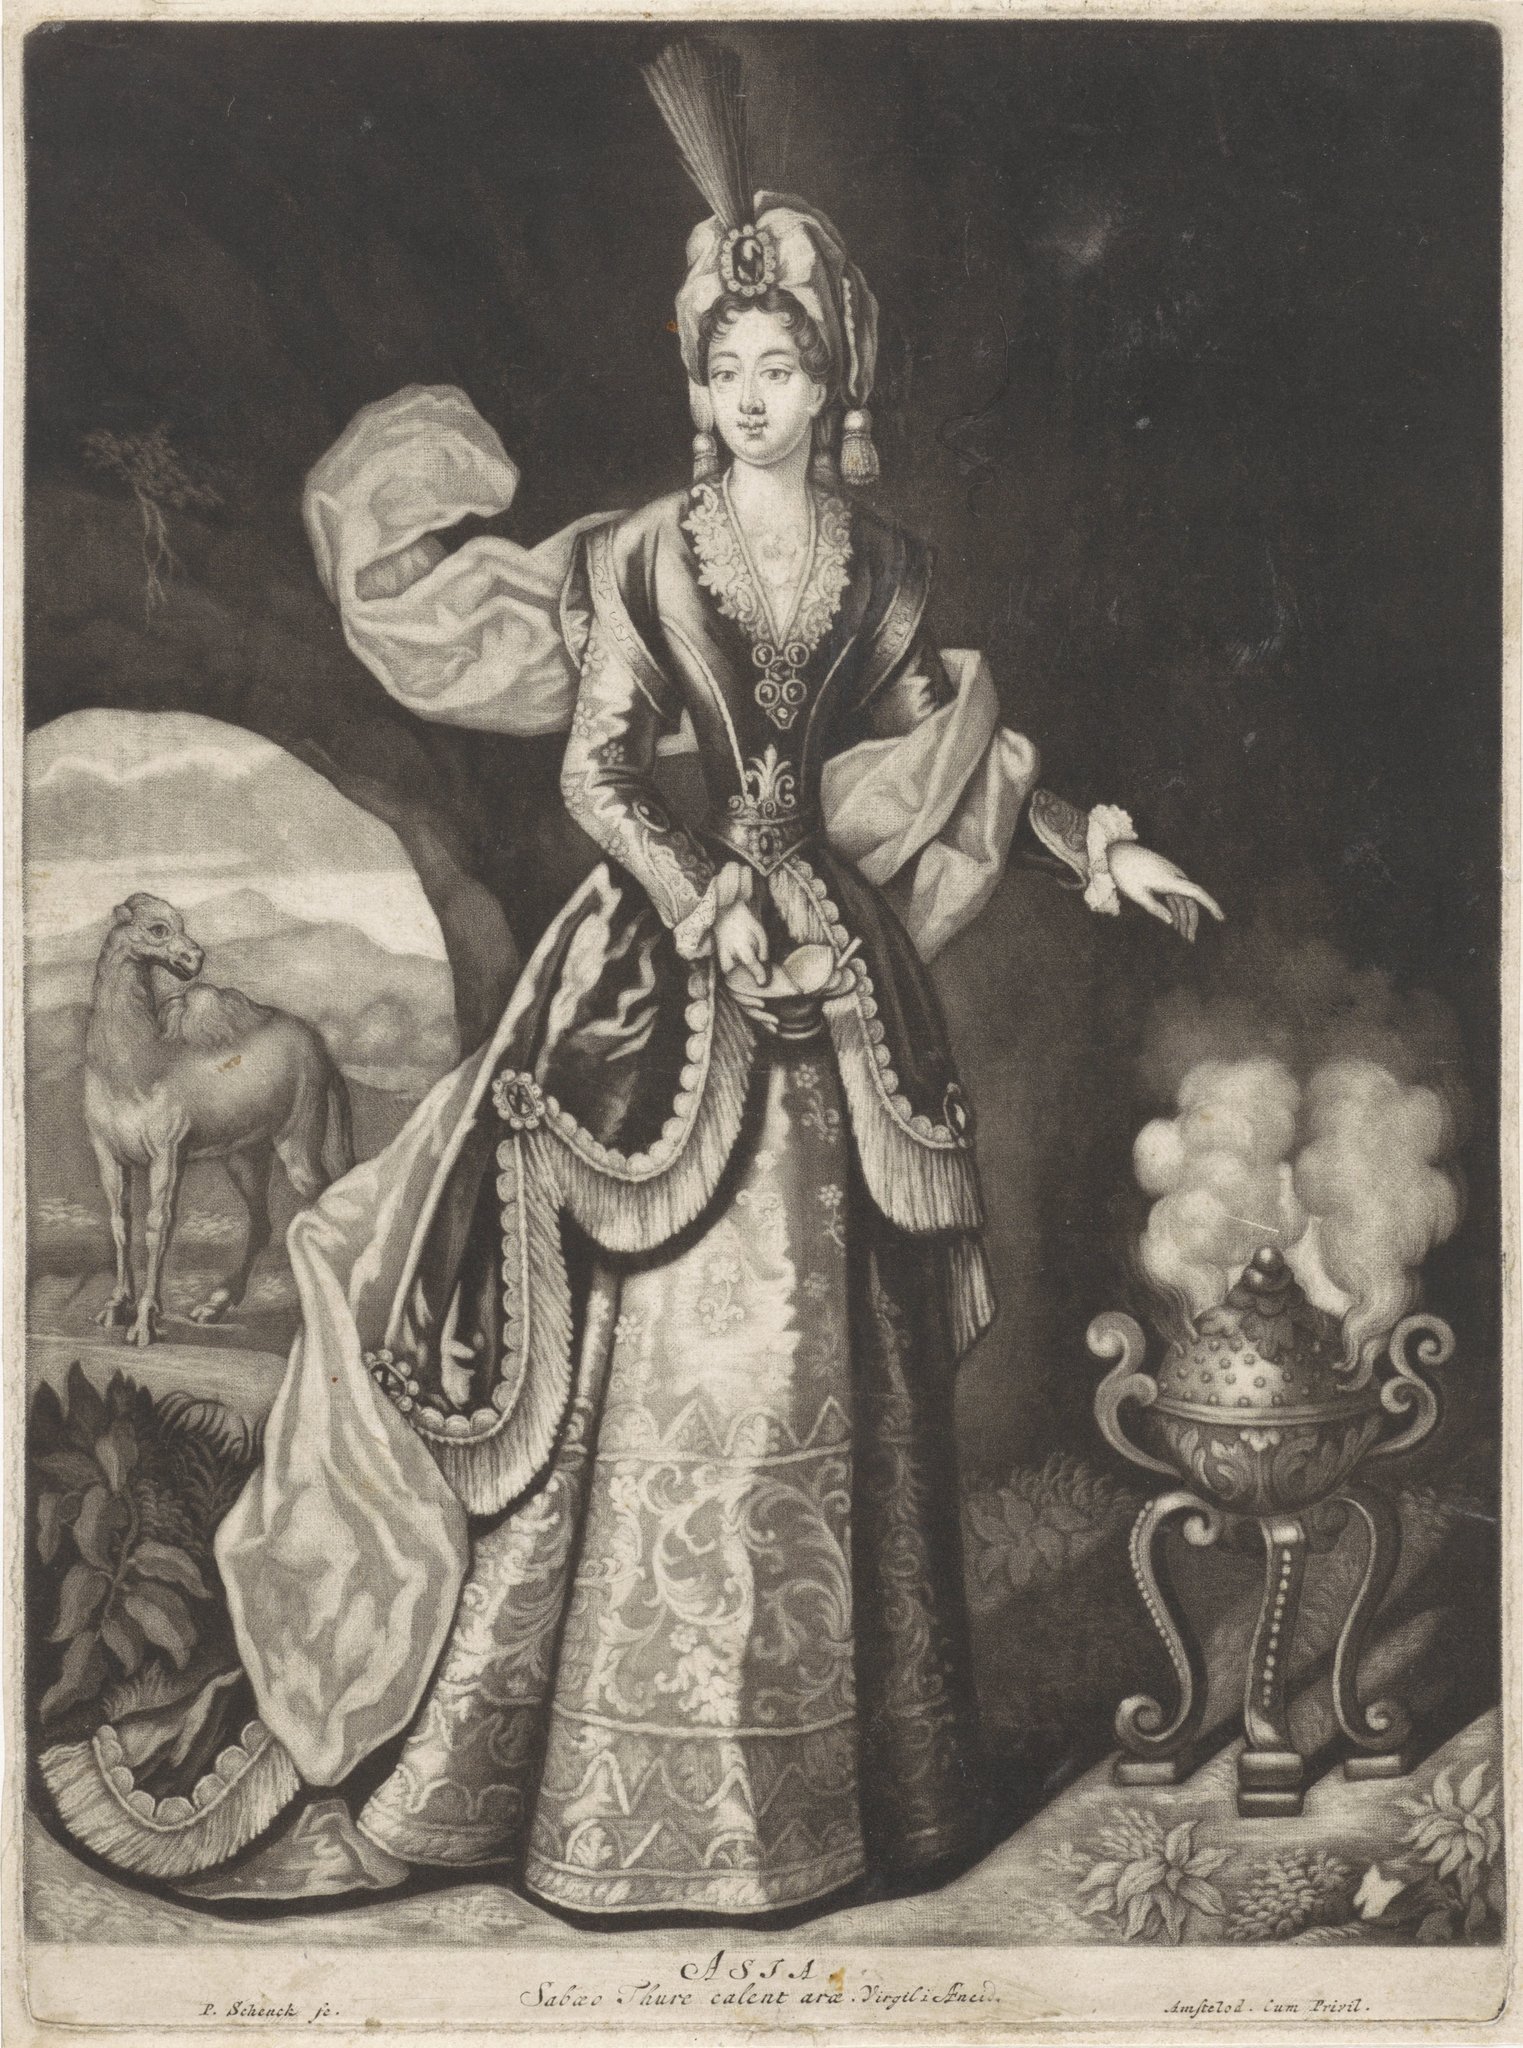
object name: print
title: De vier werelddelen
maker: pieter schenk (i)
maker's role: print maker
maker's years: 1660-1711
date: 1670-1713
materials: paper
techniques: engraving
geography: amsterdam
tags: hoofed animals: dromedary, asia represented allegorically; 'asia' (ripa), incense-burner ~ scents, perfumes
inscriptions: collector's mark: Lugt 2228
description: Het werelddeel Azië. De personificatie van Azië staat in een grot bij een wierookvat. Op de achtergrond een drommedaris.